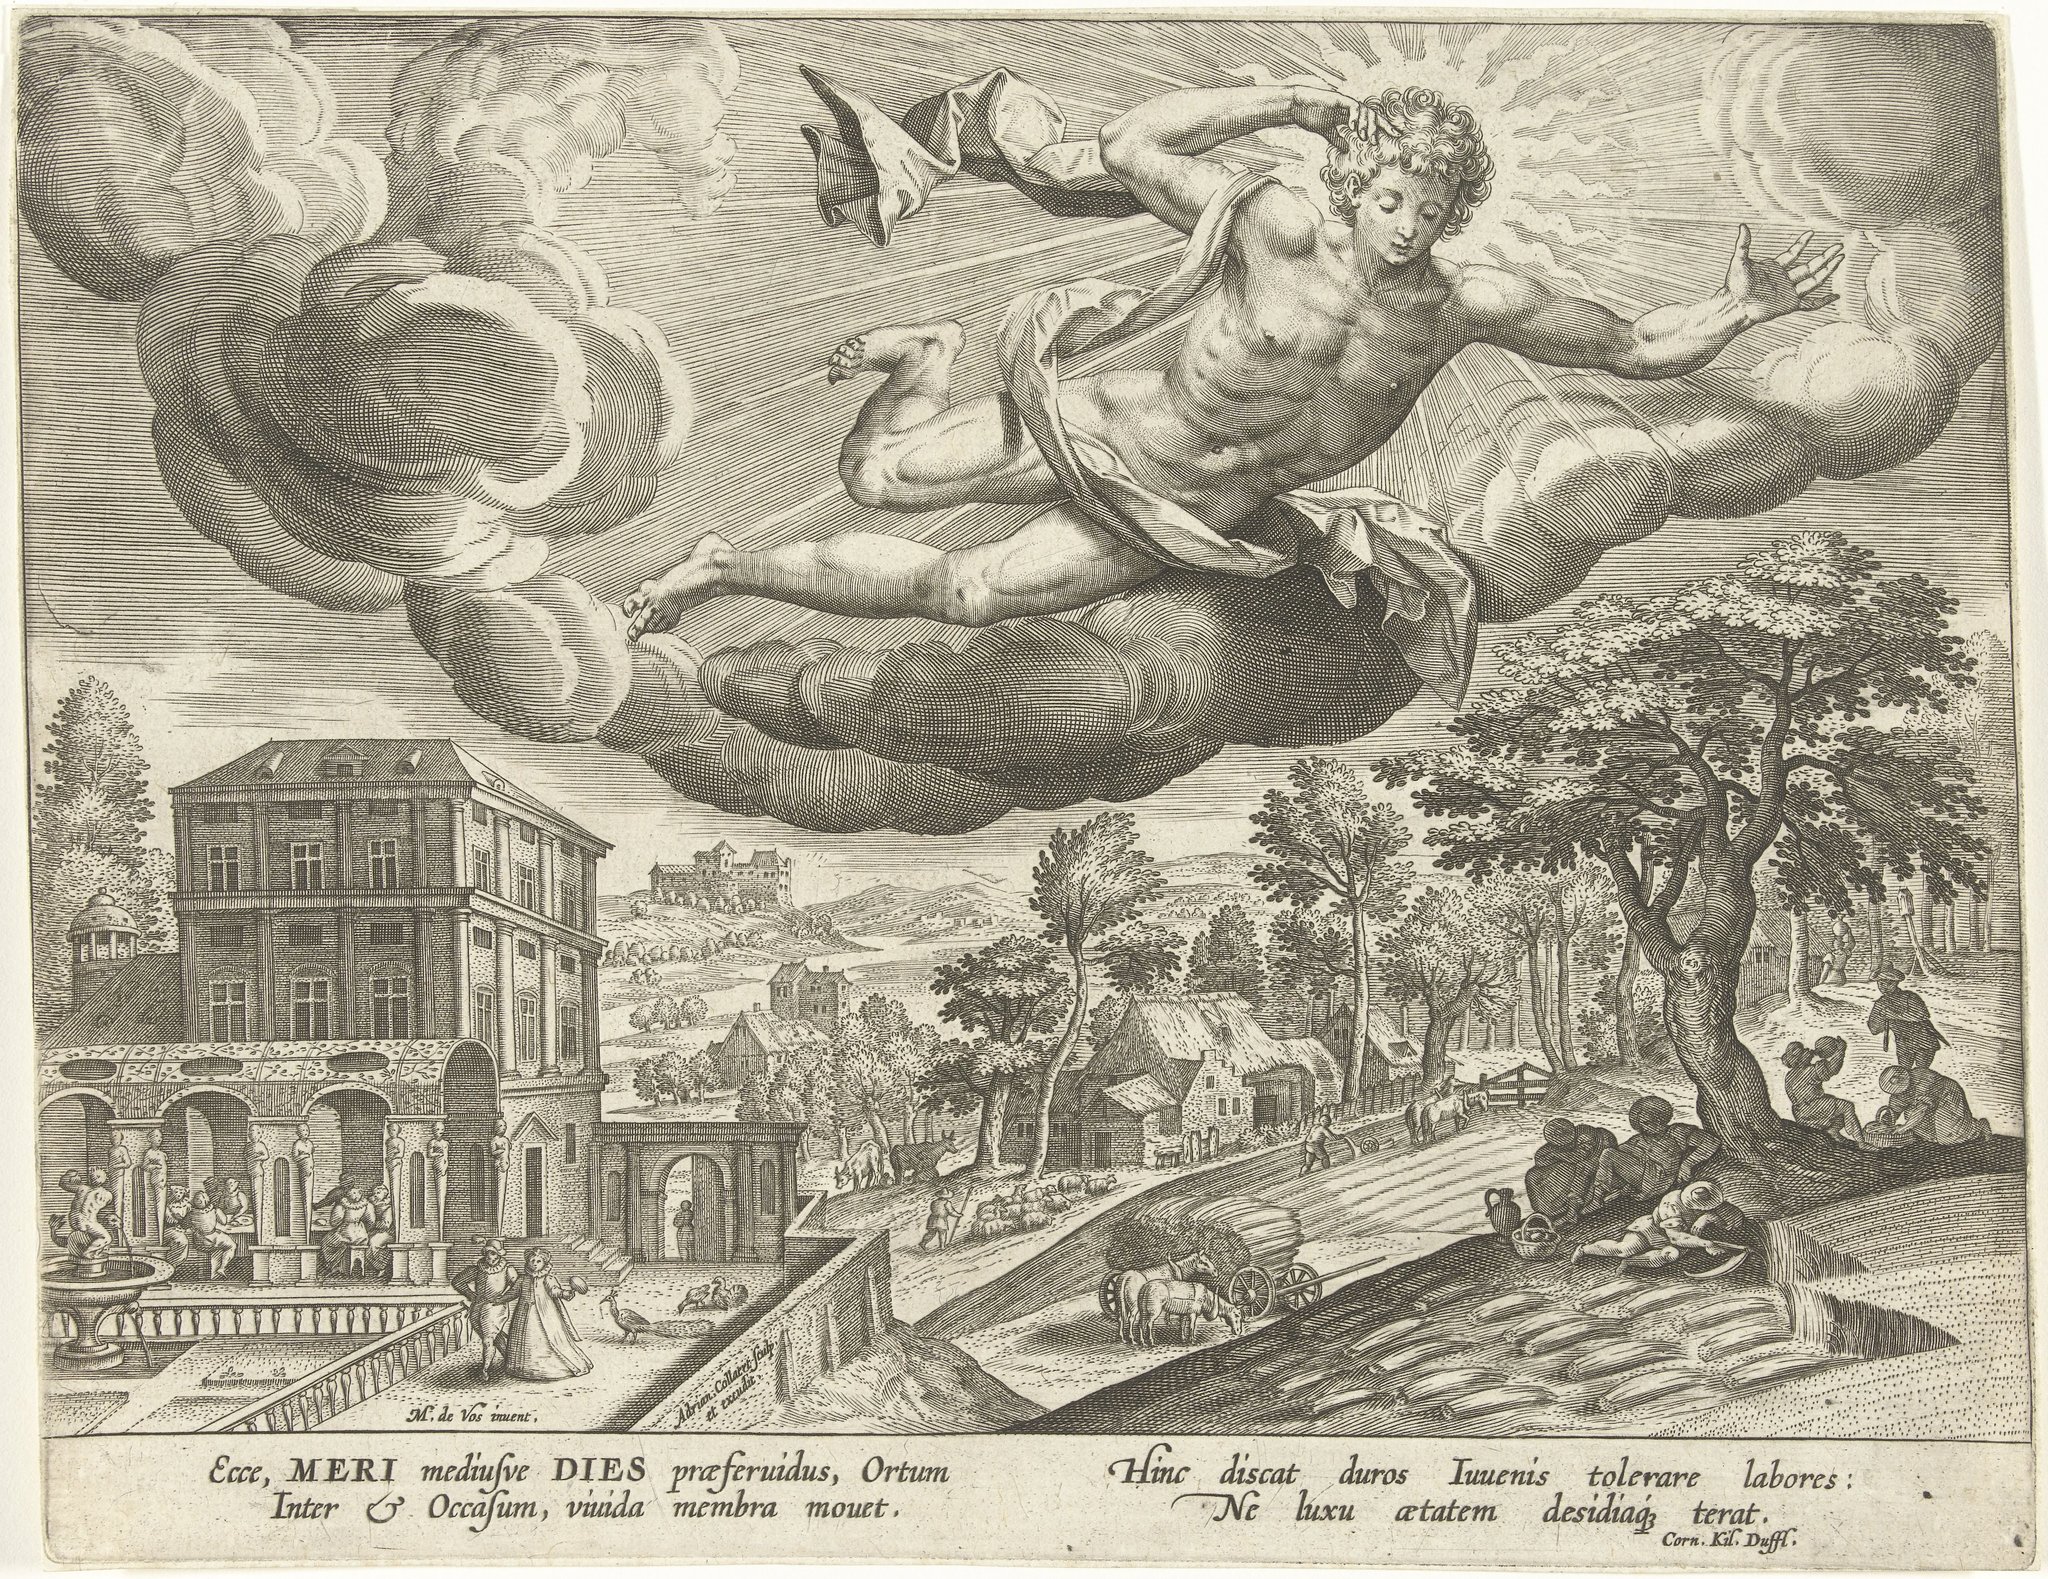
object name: print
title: De vier tijden van het etmaal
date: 1570-1597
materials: paper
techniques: engraving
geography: duffel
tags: afternoon ~ landscape (sometimes titled 'meridies')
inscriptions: collector's mark: Lugt 2228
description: Boven in de wolken de naakte personificatie van de middag, Meridiës. Achter hem de stralende zon. De achtergrond van de prent toont een landschap met wandelaars, luierende boeren en herders. De prent heeft een Latijns onderschrift en is deel van een vierdelige serie over de vier tijden van het etmaal.